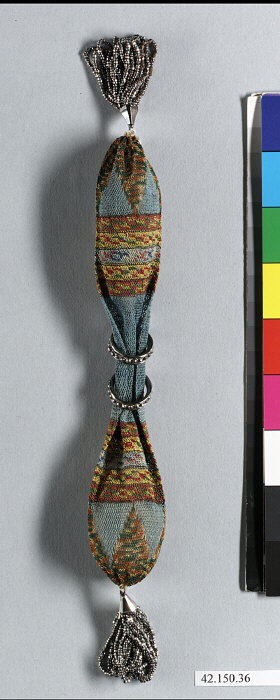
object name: purse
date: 1801-1833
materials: silk, steel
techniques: cutting, embroidery